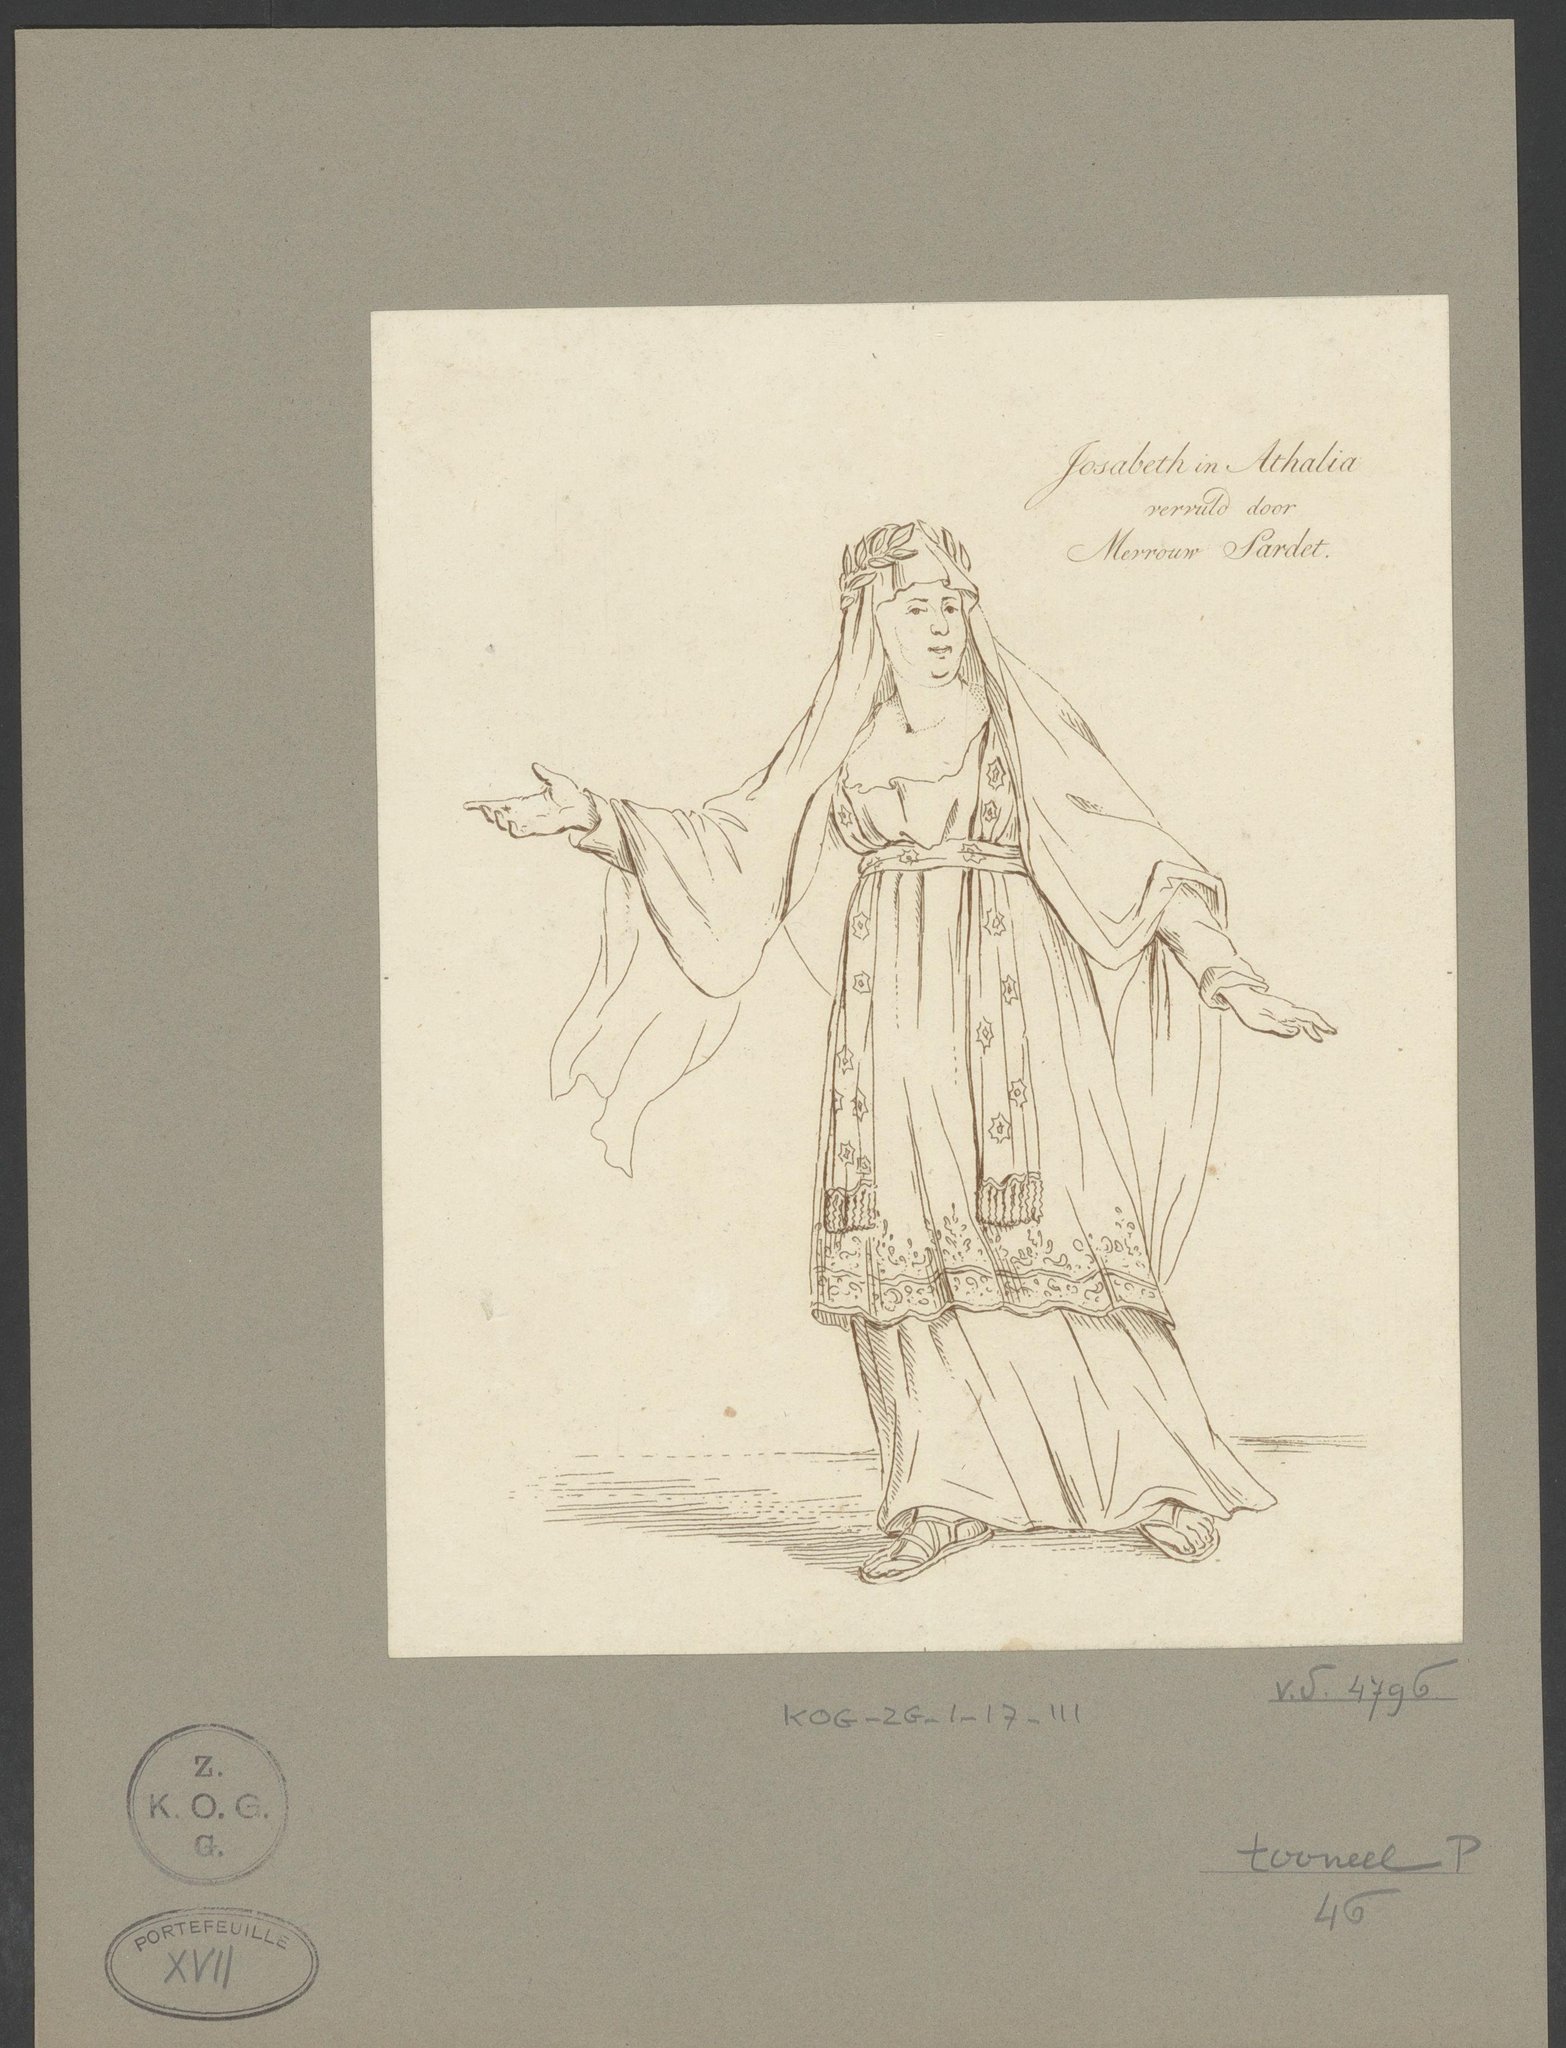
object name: print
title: Mevrouw Sardet in de rol van Josabeth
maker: johannes jelgerhuis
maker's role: draughtsman, painter, print maker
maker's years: 1770-1836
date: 1805-1836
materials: paper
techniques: etching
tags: actor (on the stage)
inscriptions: stamp, collector's mark: Lugt 1641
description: De actrice mevrouw Sardet als Josabeth, gekleed in Grieks gewaad. Een sluier met lauwerkrans op het hoofd. Prent uit een serie van tien met Nederlandse acteurs en actrices in verschillende rollen. Onderwerpsrubrieken binnen de Atlas Zeden en Gewoonten: Tooneel, Portretten van toneelspelers.